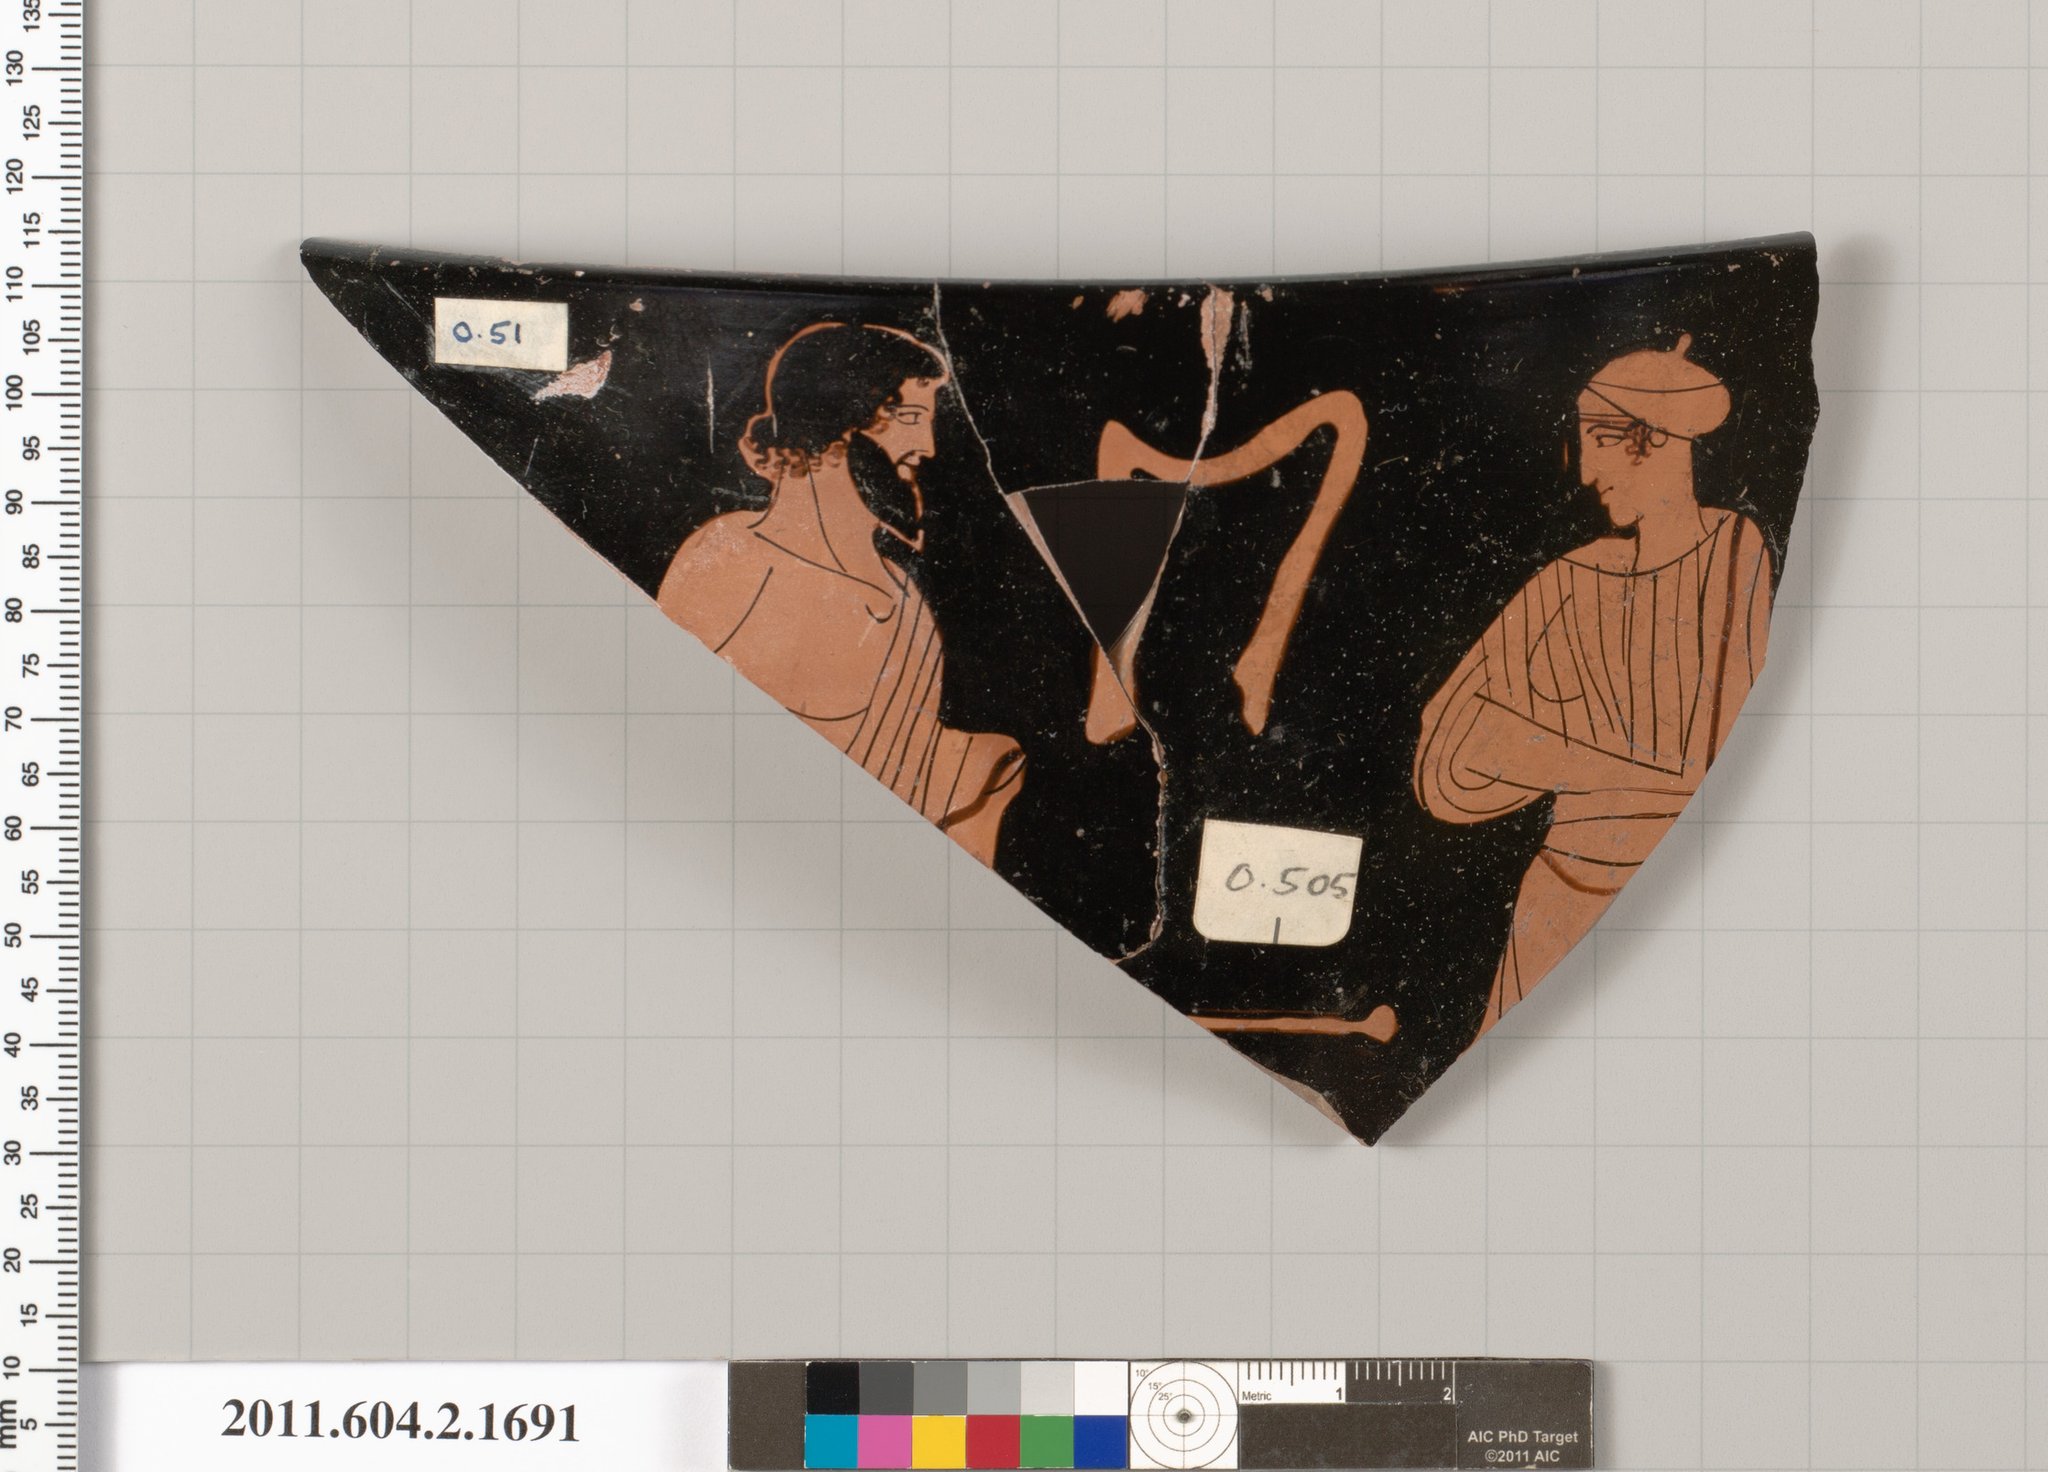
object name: skyphos fragment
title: Terracotta fragment of a skyphos (deep drinking cup)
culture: greek, attic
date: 460-450 BCE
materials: terracotta